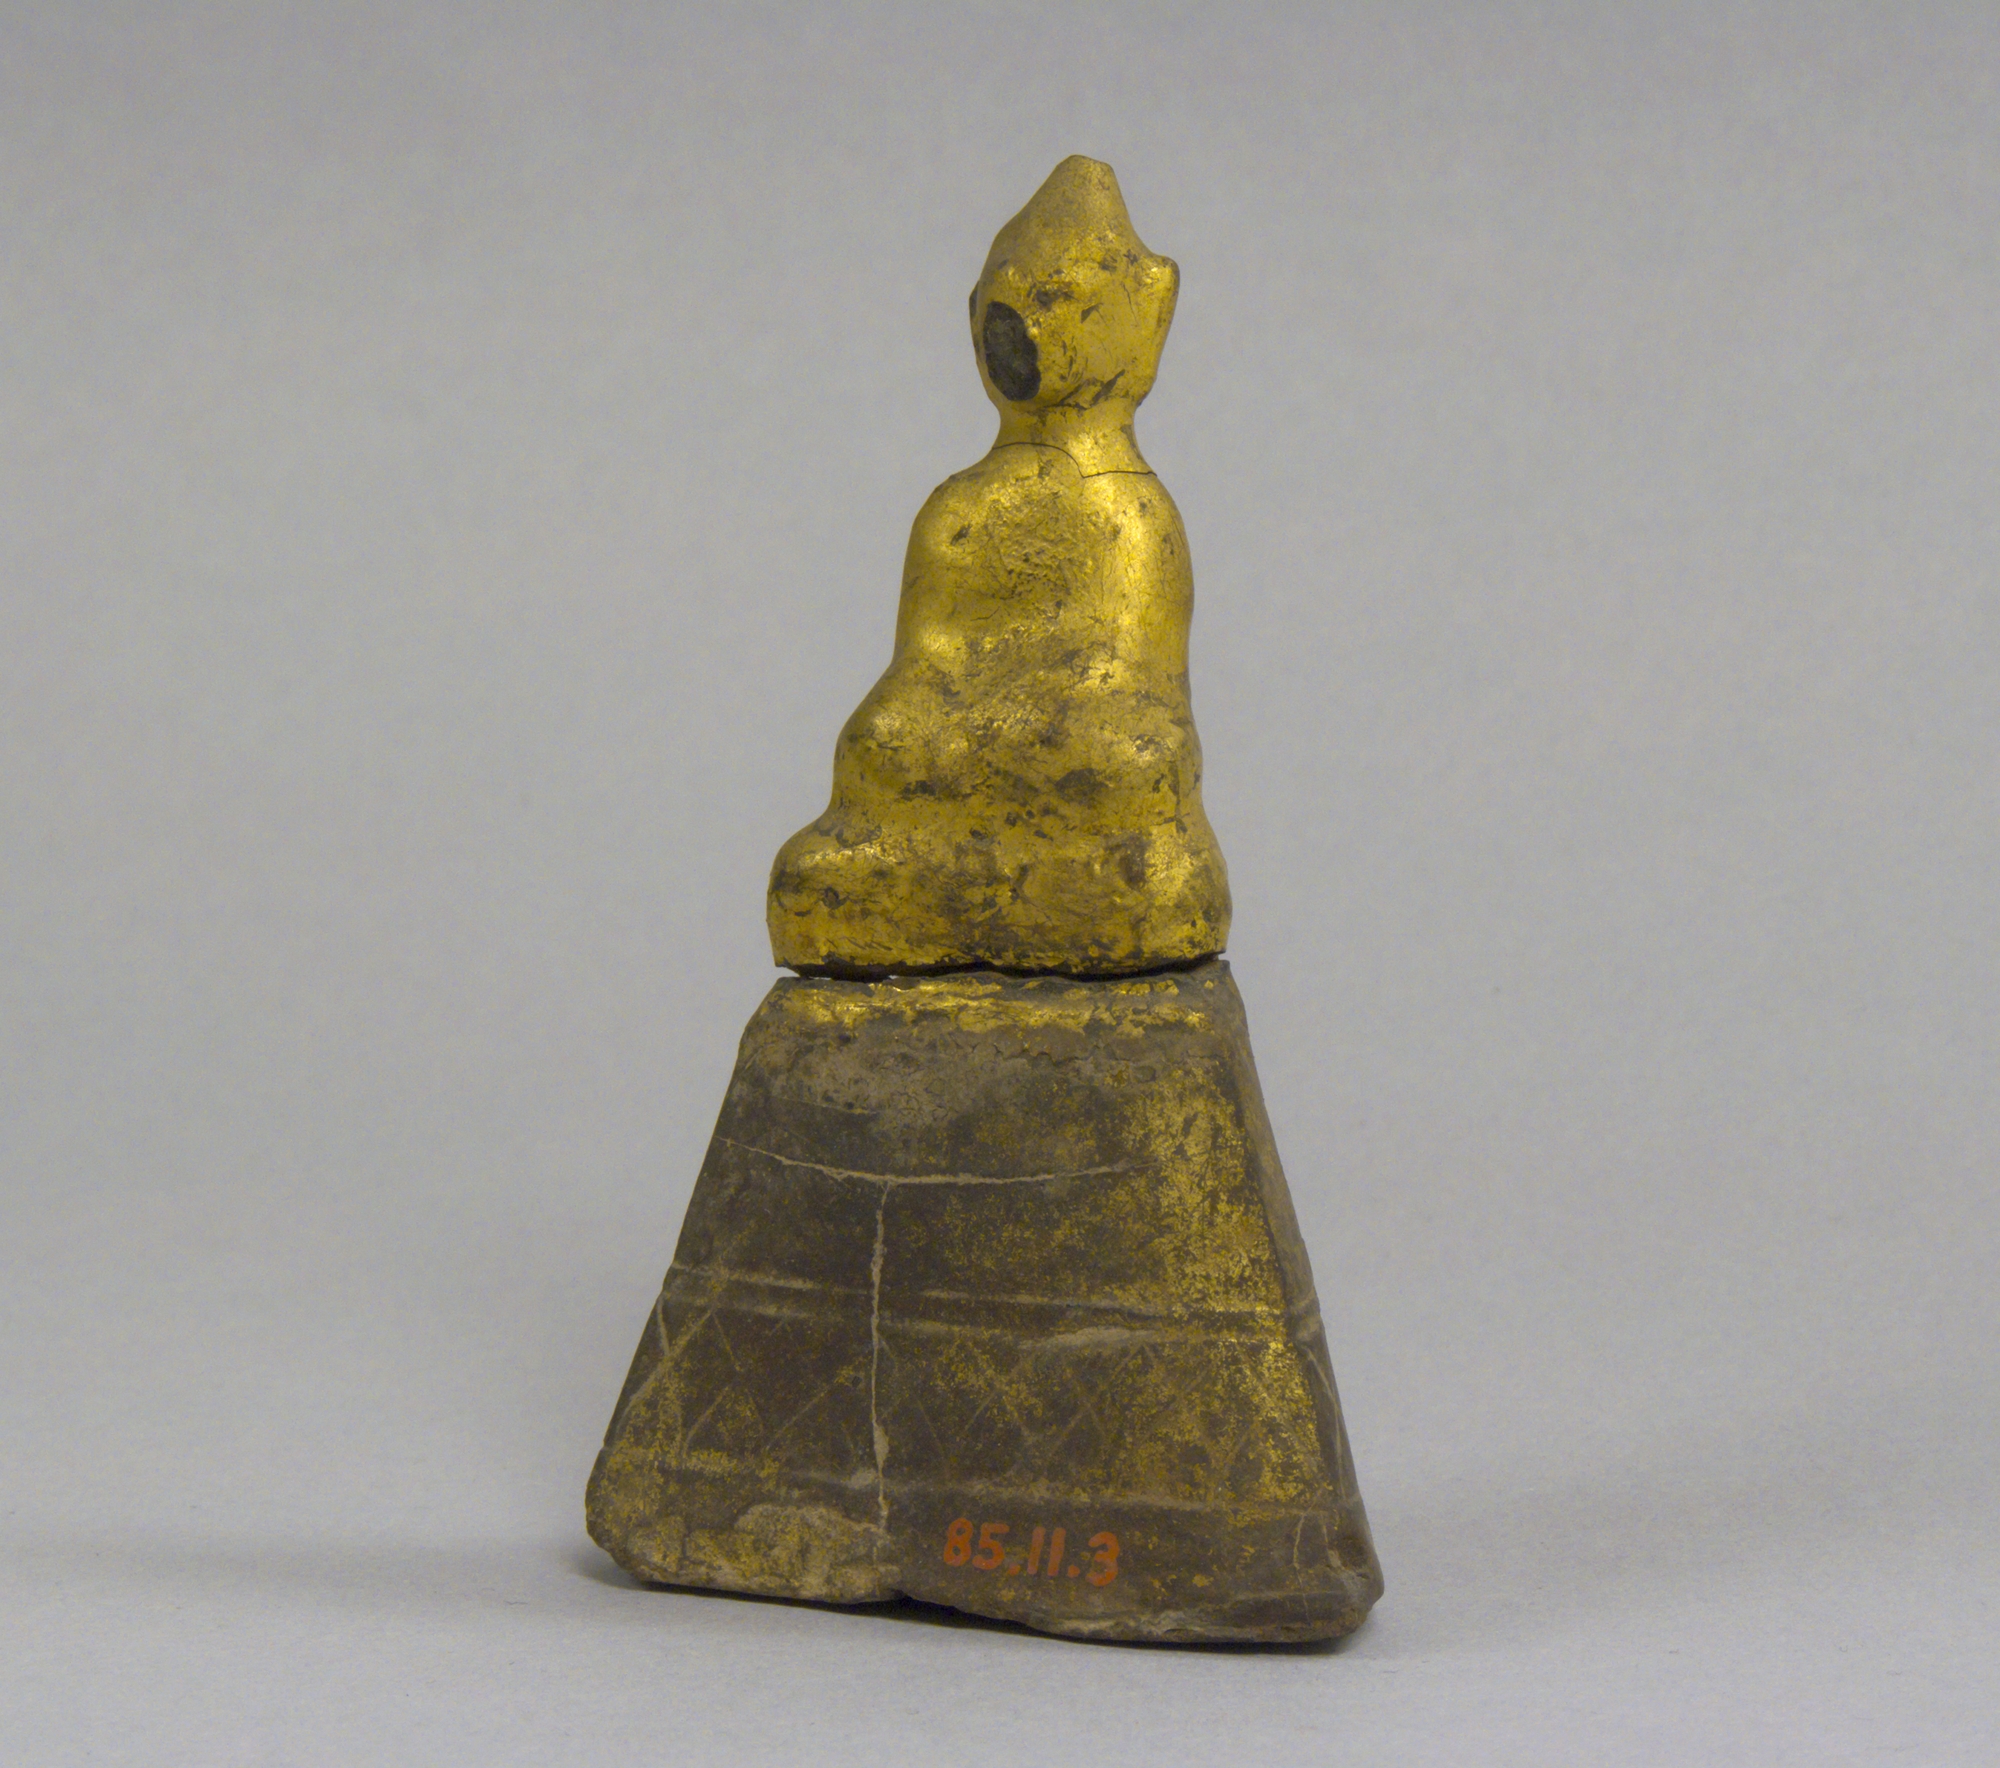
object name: statuette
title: Seated Buddha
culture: cambodian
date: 1501-1600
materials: gilt, lacquer, silver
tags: buddhism,buddha